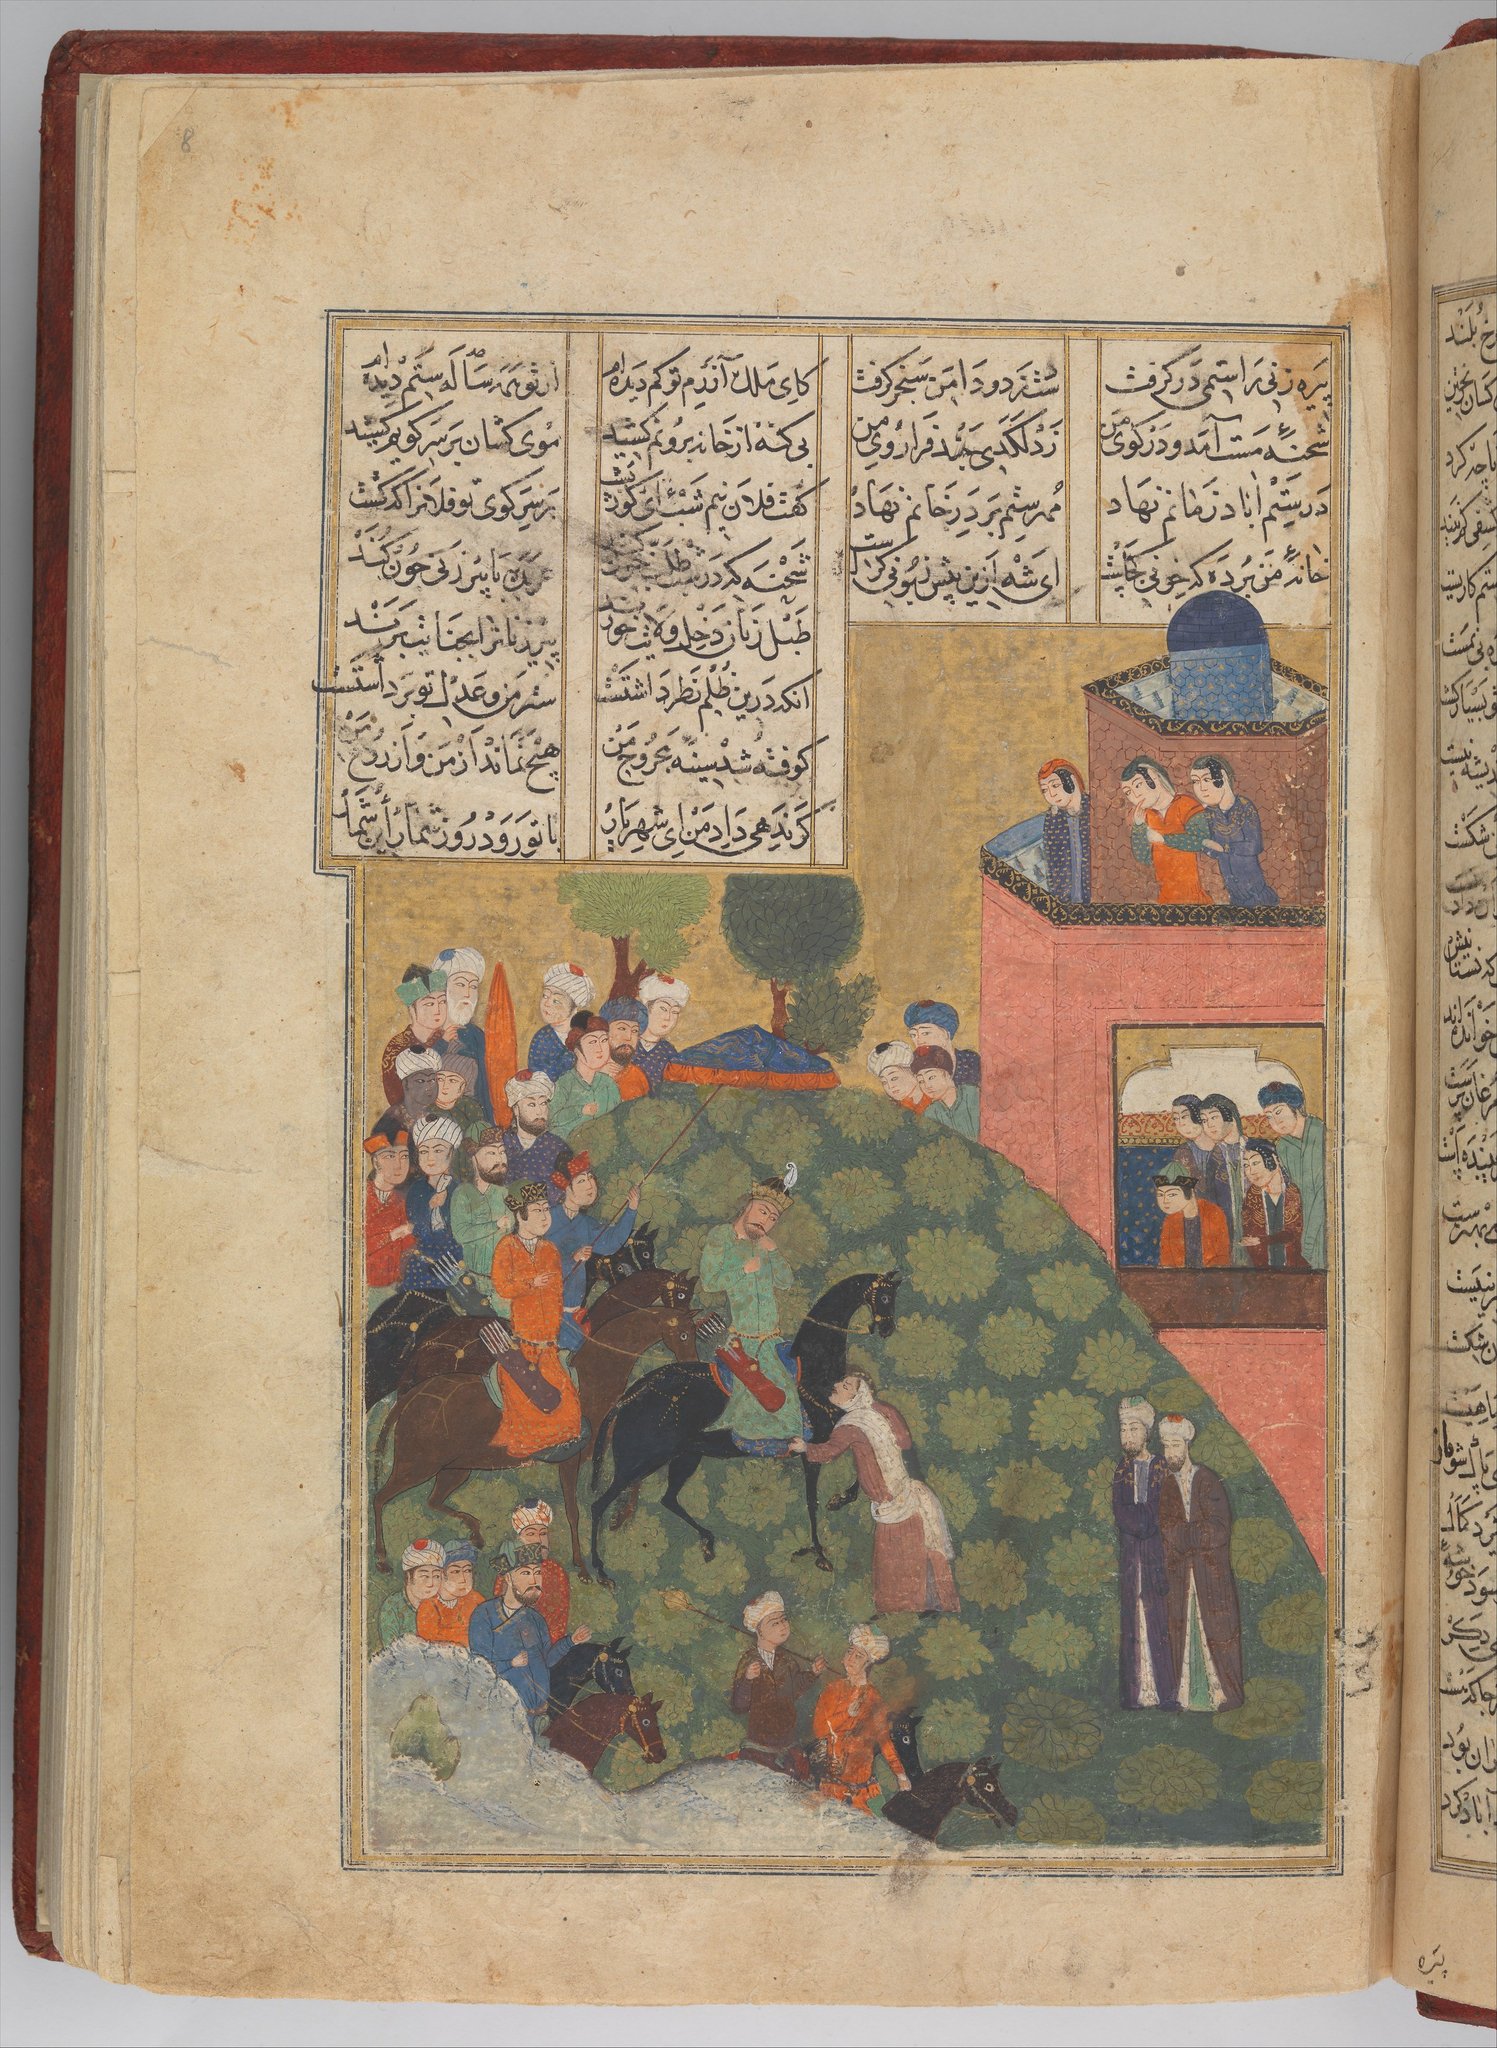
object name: illustrated manuscript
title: Khamsa (Quintet) of Nizami of Ganja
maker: nizami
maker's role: author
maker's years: 1141-1209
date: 1401-1500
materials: gold, ink, paper, silver, watercolor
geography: iran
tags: men,women,hunting,camels,horses